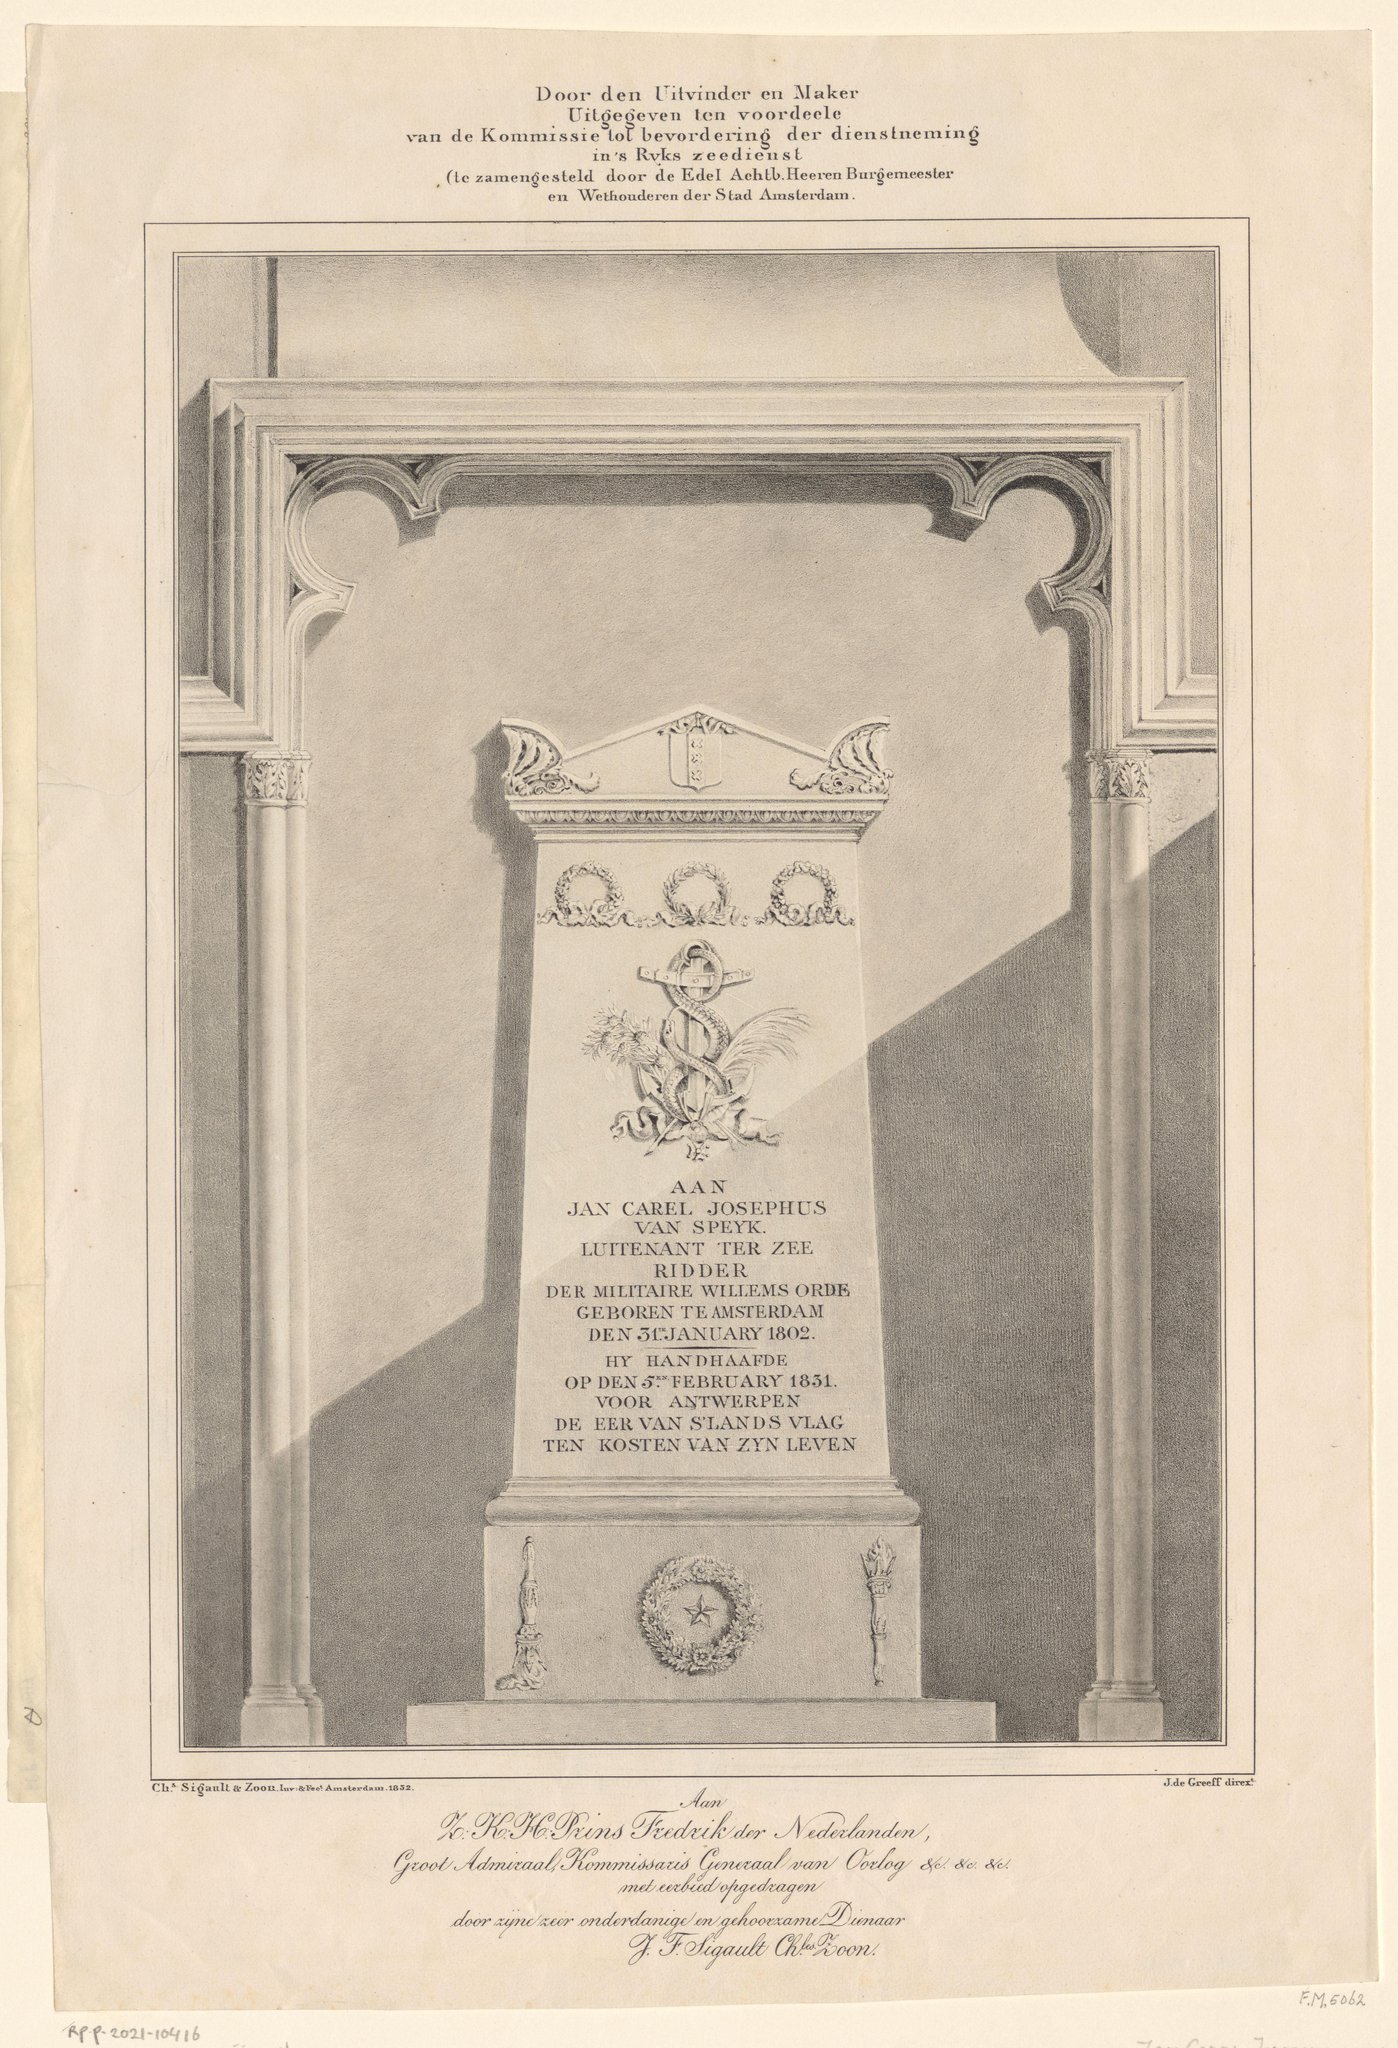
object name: print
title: Grafmonument van Jan van Speyk in de Nieuwe Kerk te Amsterdam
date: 1832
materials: paper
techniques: lithograph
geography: amsterdam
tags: amsterdam, antwerp, jan van speyk, historical persons, architecture, grave, tomb and other grave-forms and grave-markers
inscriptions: collector's mark: Lugt 2228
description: Het monument bevindt zich in de Nieuwe Kerk Amsterdam.